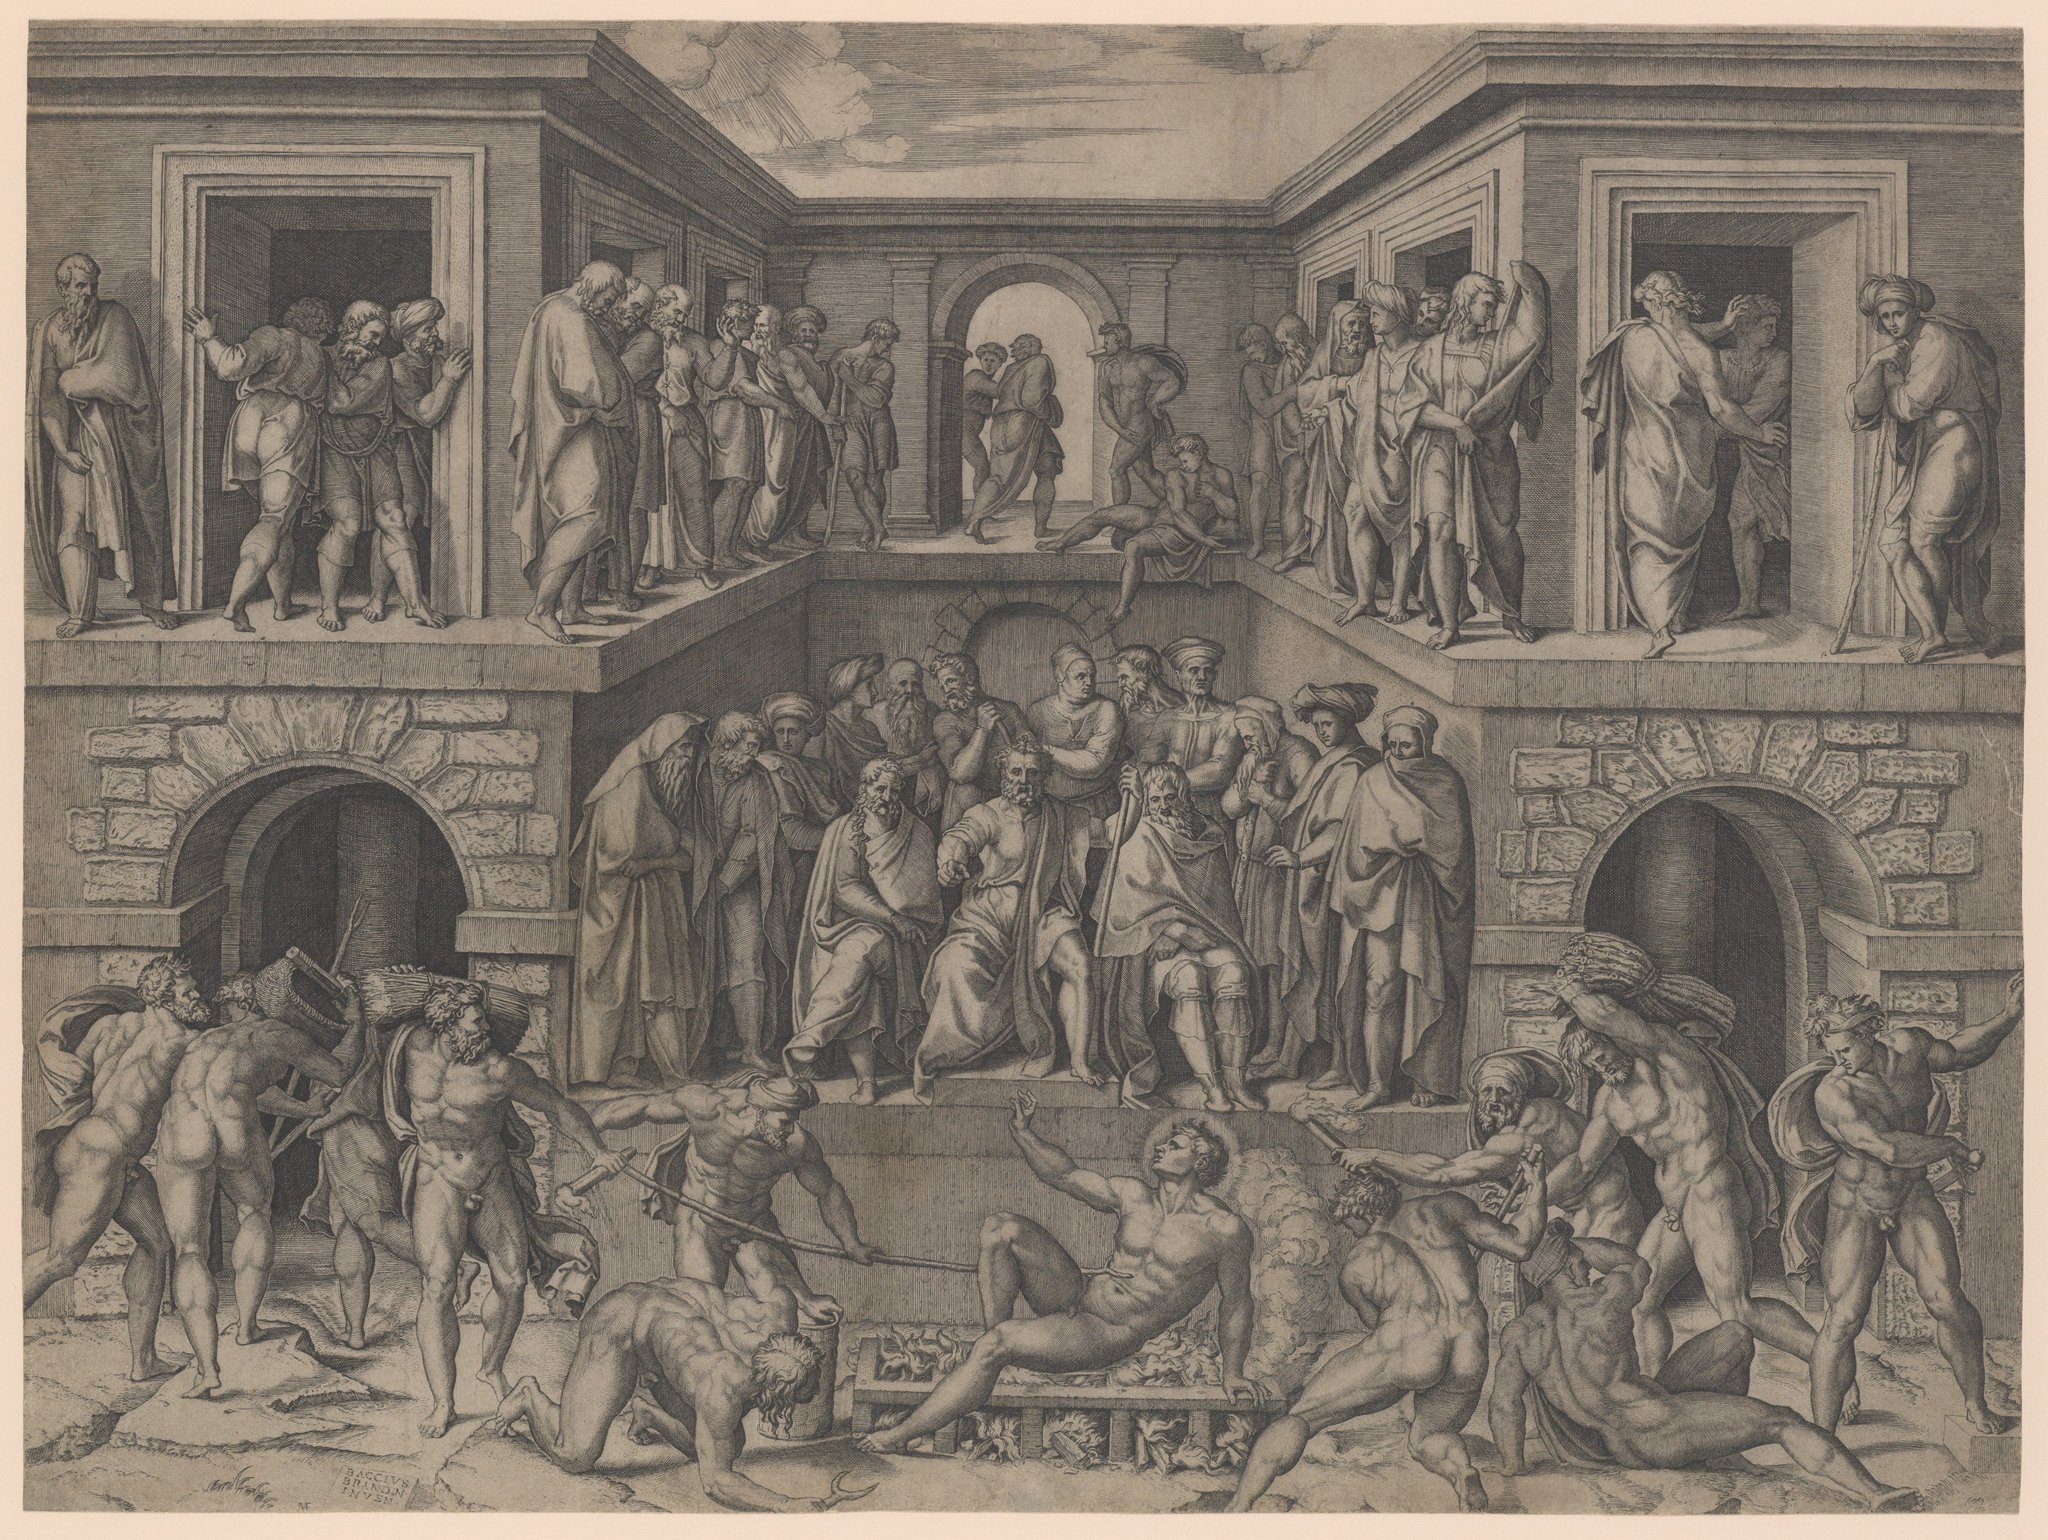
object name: print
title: The Martyrdom of Saint Lawrence, after Bandinelli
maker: marcantonio raimondi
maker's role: artist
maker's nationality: italian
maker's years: 1475-1534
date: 1520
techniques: engraving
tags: suffering,men,male nudes,saint lawrence